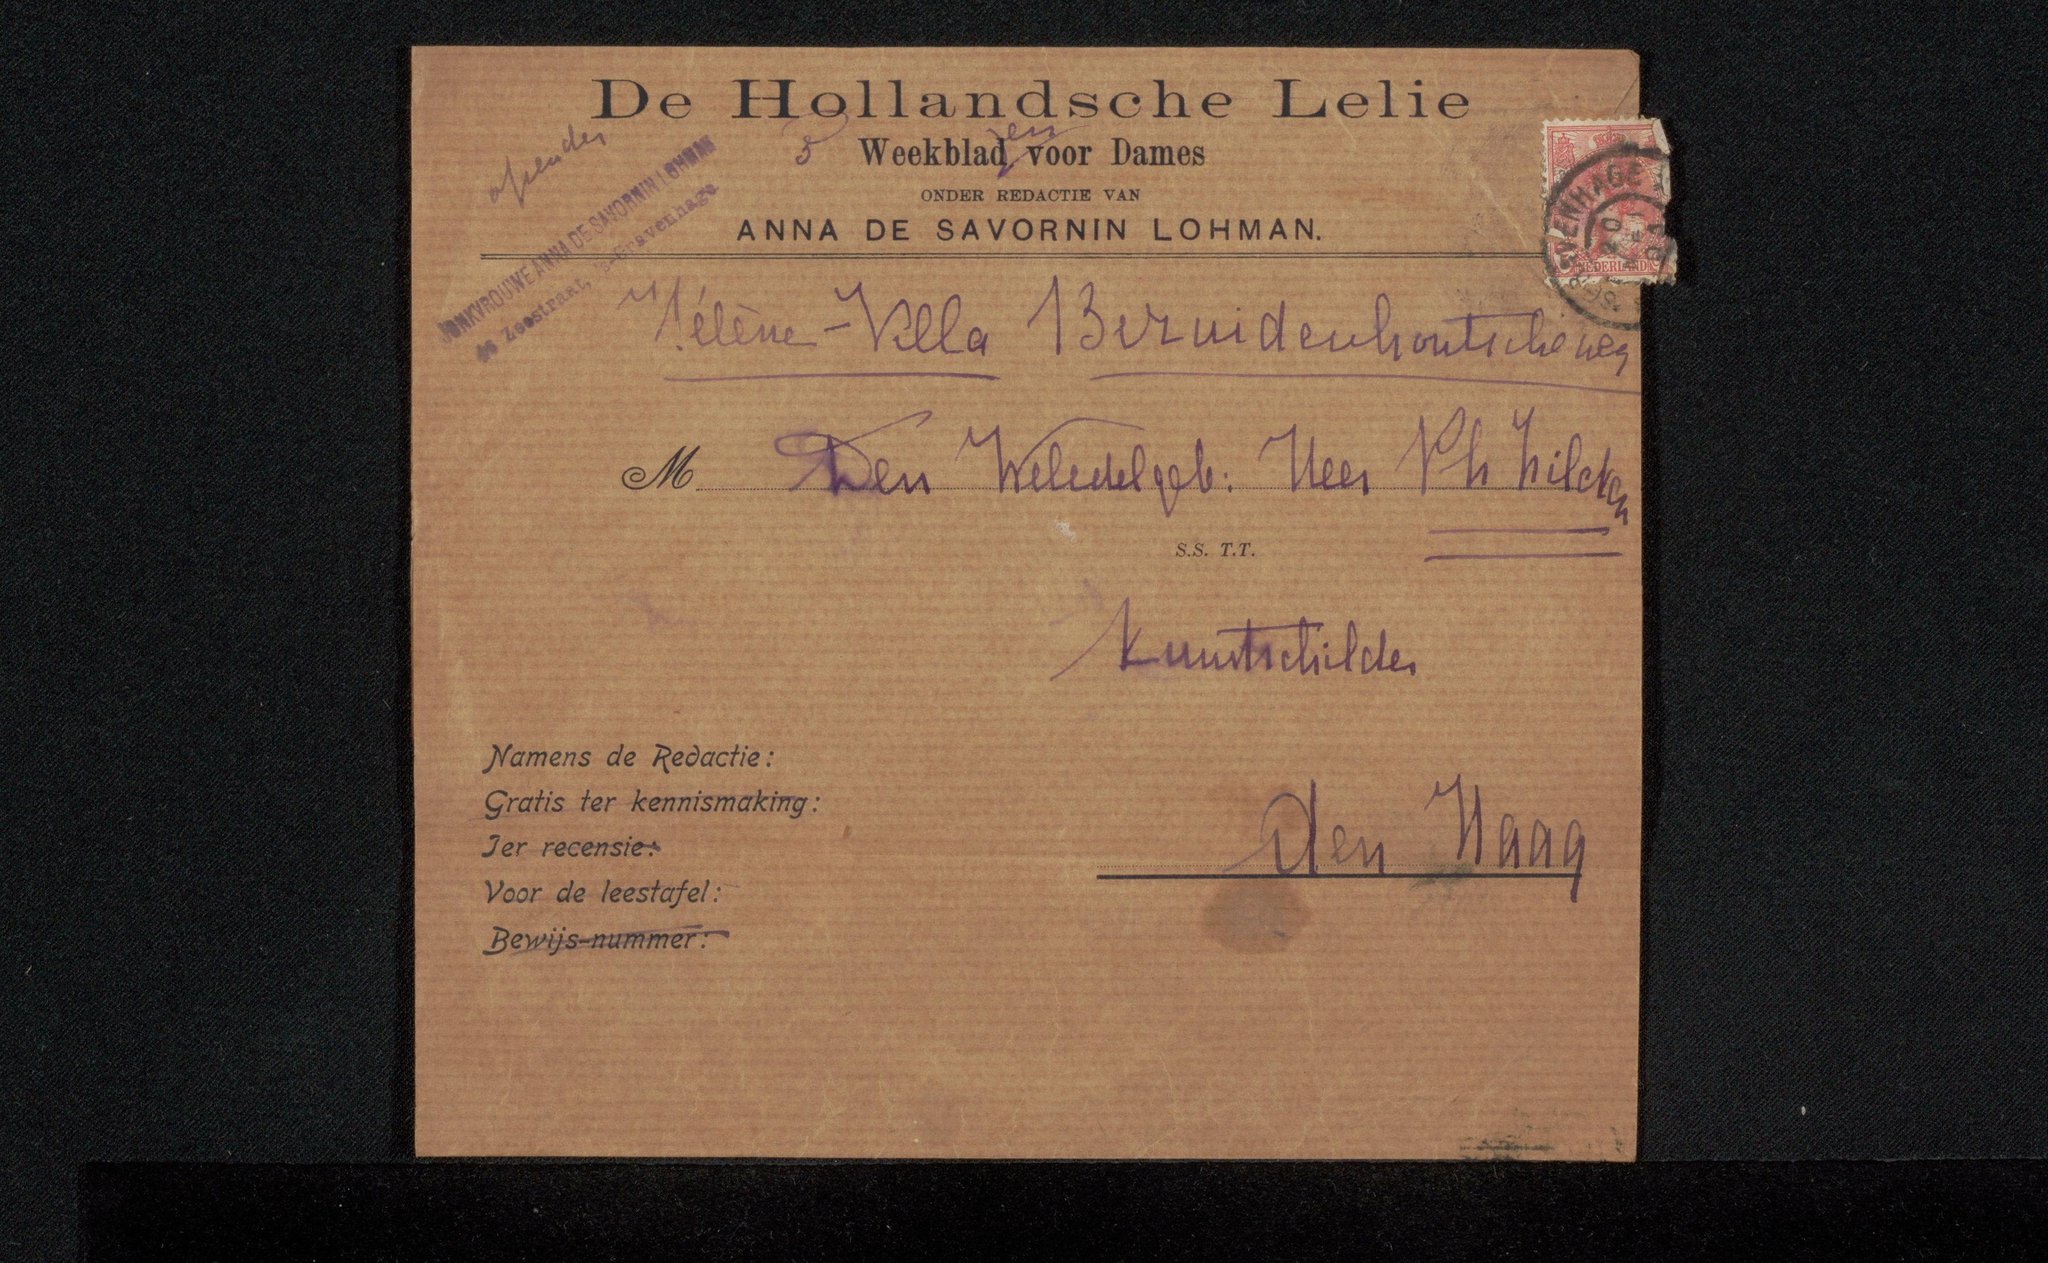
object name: envelope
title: Envelop aan Philip Zilcken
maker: jonkvrouw catharina anna maria de savornin lohman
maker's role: criticus, journalist, schrijver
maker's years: 1868-1930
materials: ink, paper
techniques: pen, printing, writing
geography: the hague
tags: painter, draughtsman, philip zilcken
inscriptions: collector's mark: ‘RPK’, name: ‘JONKVROUWE ANNA DE SAVORNIN LOHMAN/ de Zeestraat, 's-Gravenhage.’